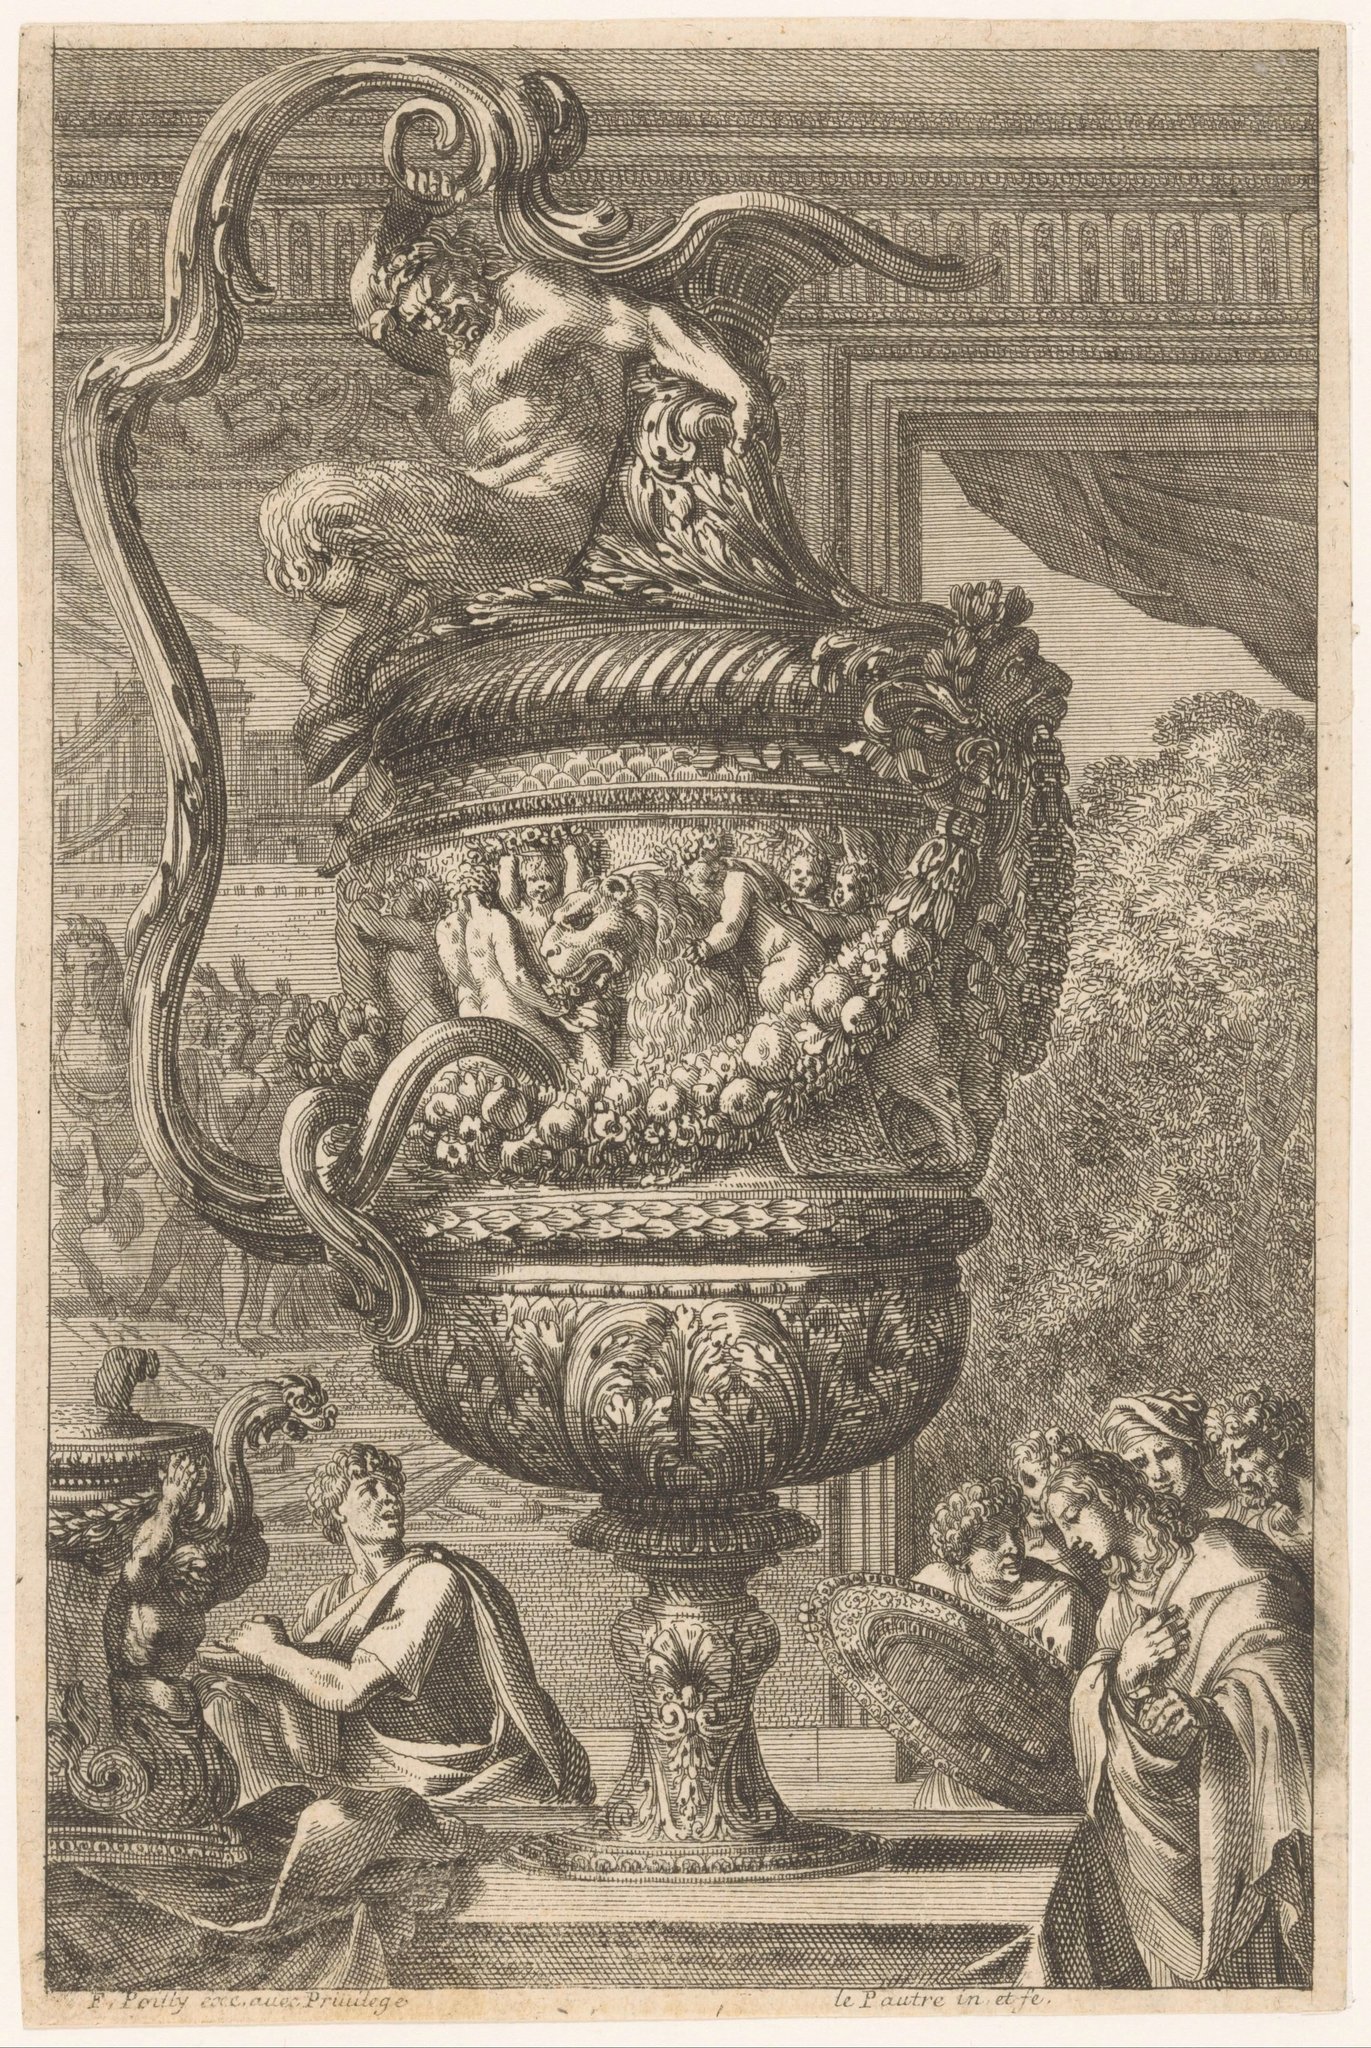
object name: ornament print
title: Schenkkan met fries en sater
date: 1669-1693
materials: paper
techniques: etching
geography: paris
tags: jar, jug (used as drinking-vessel)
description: Kan met op het lichaam een fries met putti en een leeuw. Een sater ondersteunt het handvat.